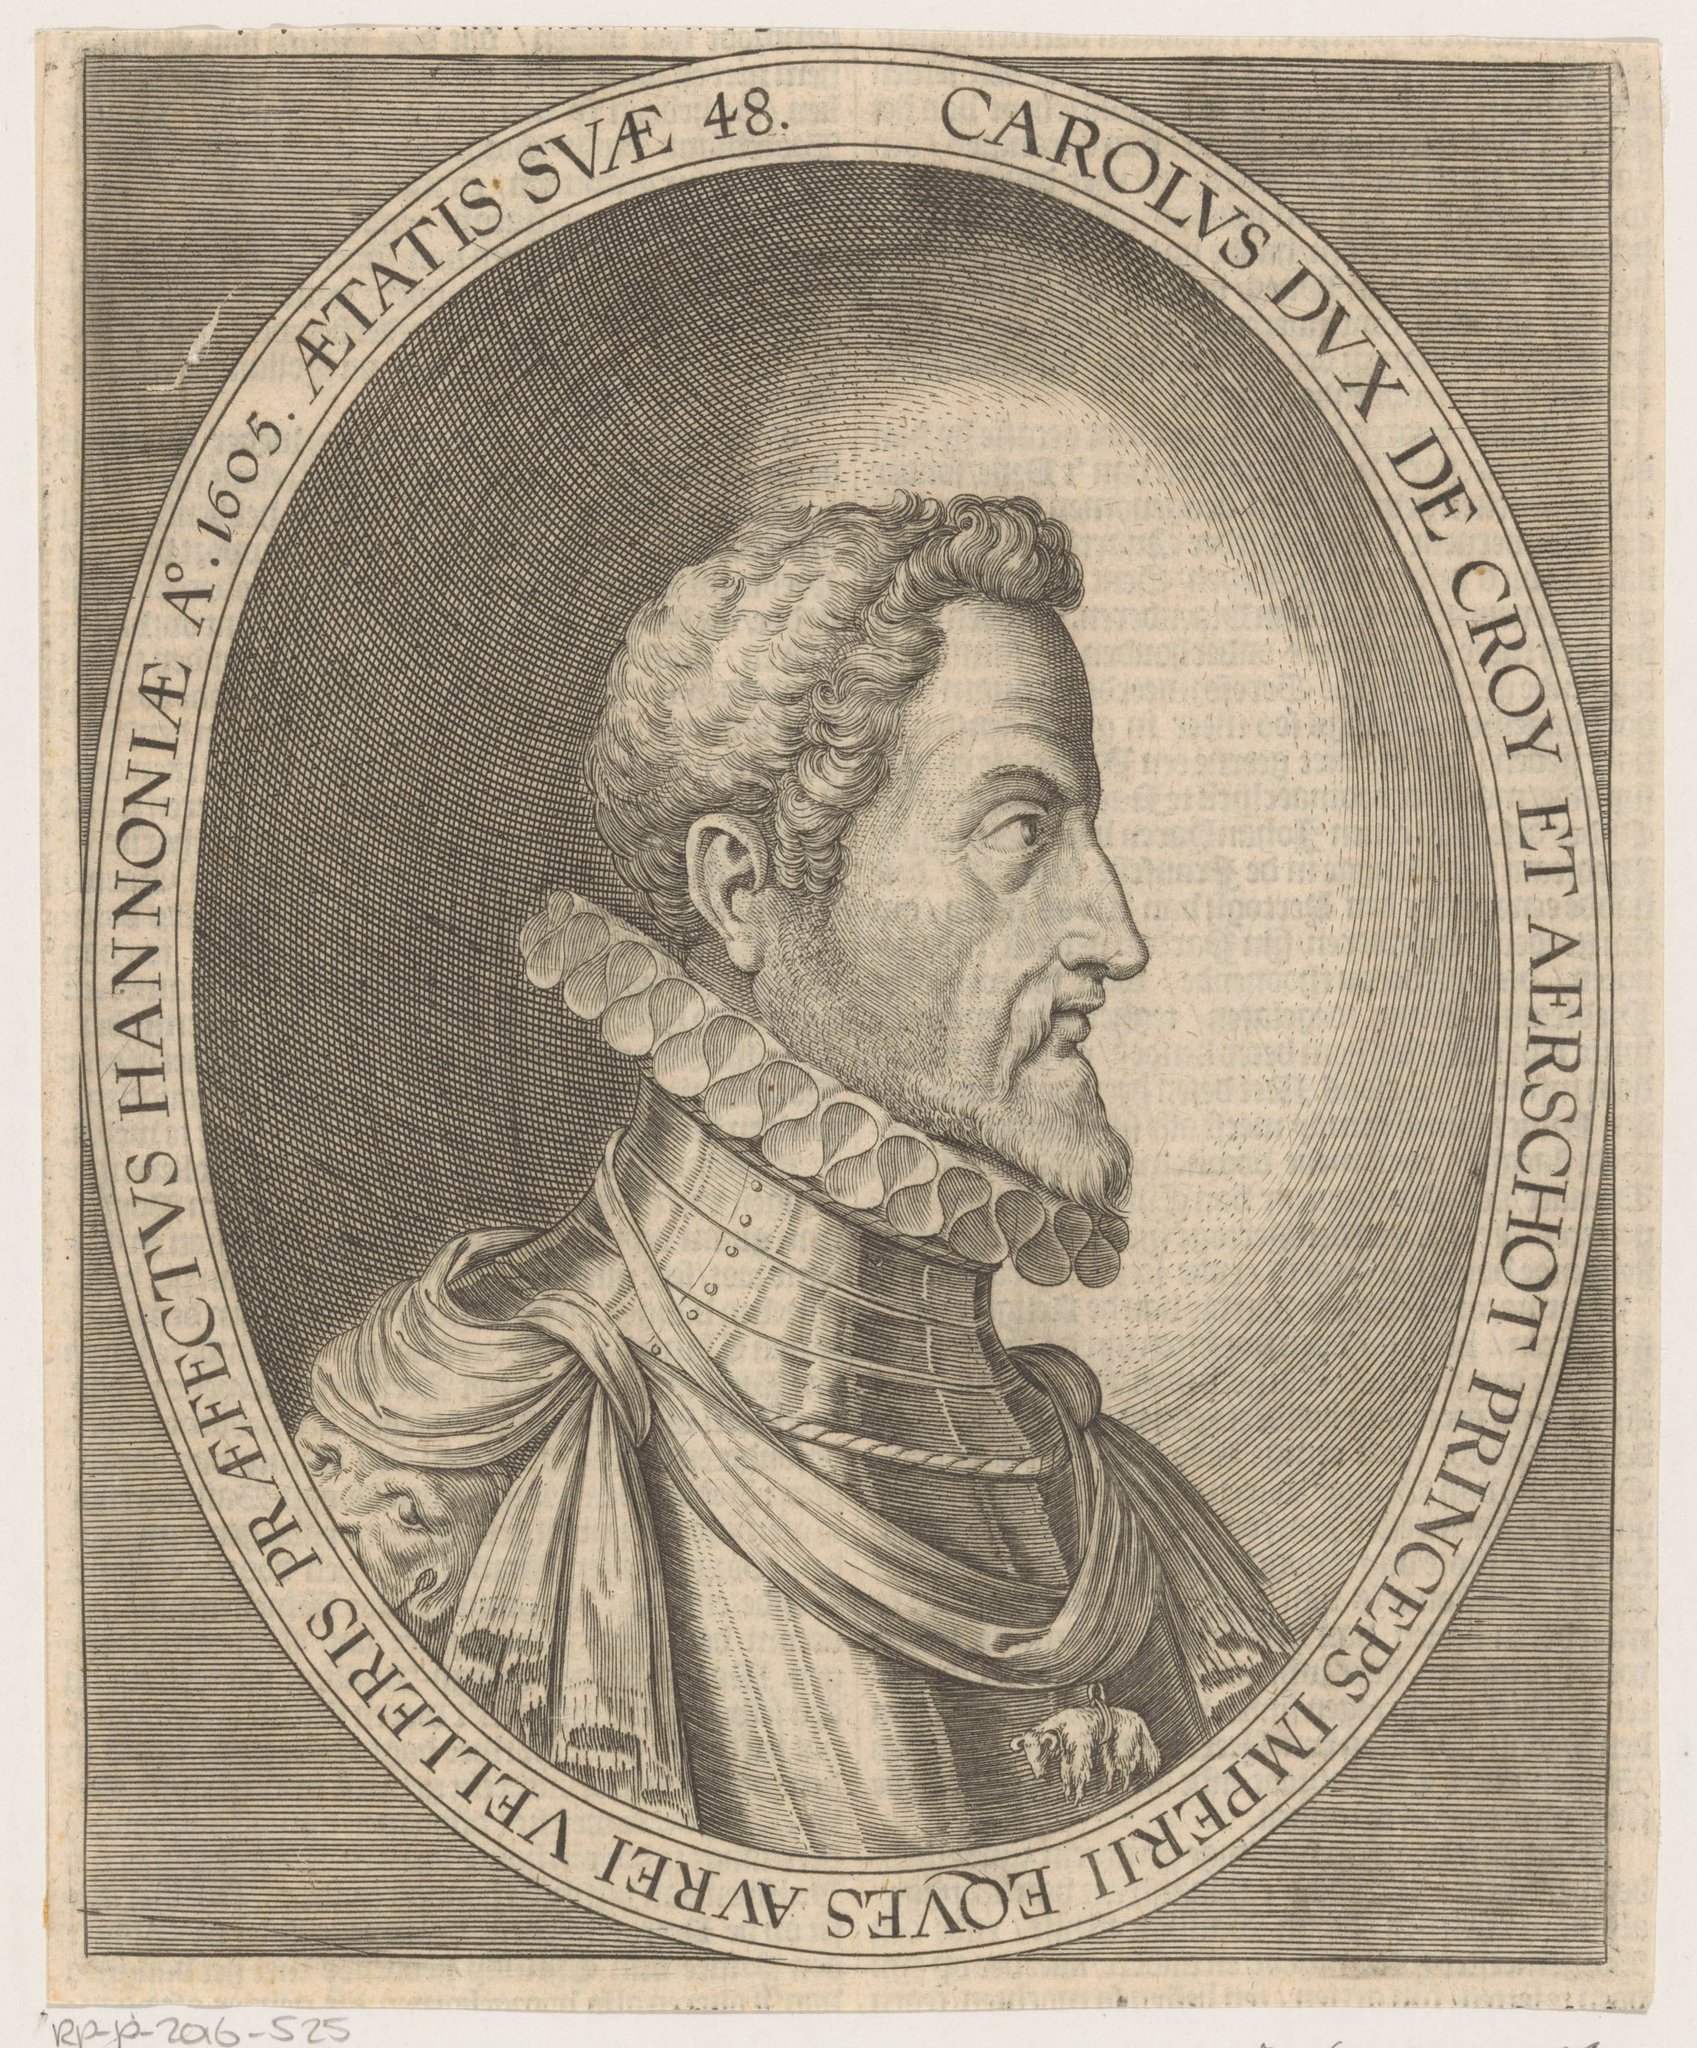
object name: book illustration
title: Portret van Karel III van Croÿ, hertog van Aarschot, op 48-jarige leeftijd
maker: Anonymous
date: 1608-1699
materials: paper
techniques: engraving, letterpress printing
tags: earl, karel iii van croÿ (hertog van aarschot), knighthood order of the golden fleece - insignia of a knighthood order, e.g.: badge, chain (with name of order)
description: Portret van Karel III van Croÿ in een ovale omlijsting met randschrift.